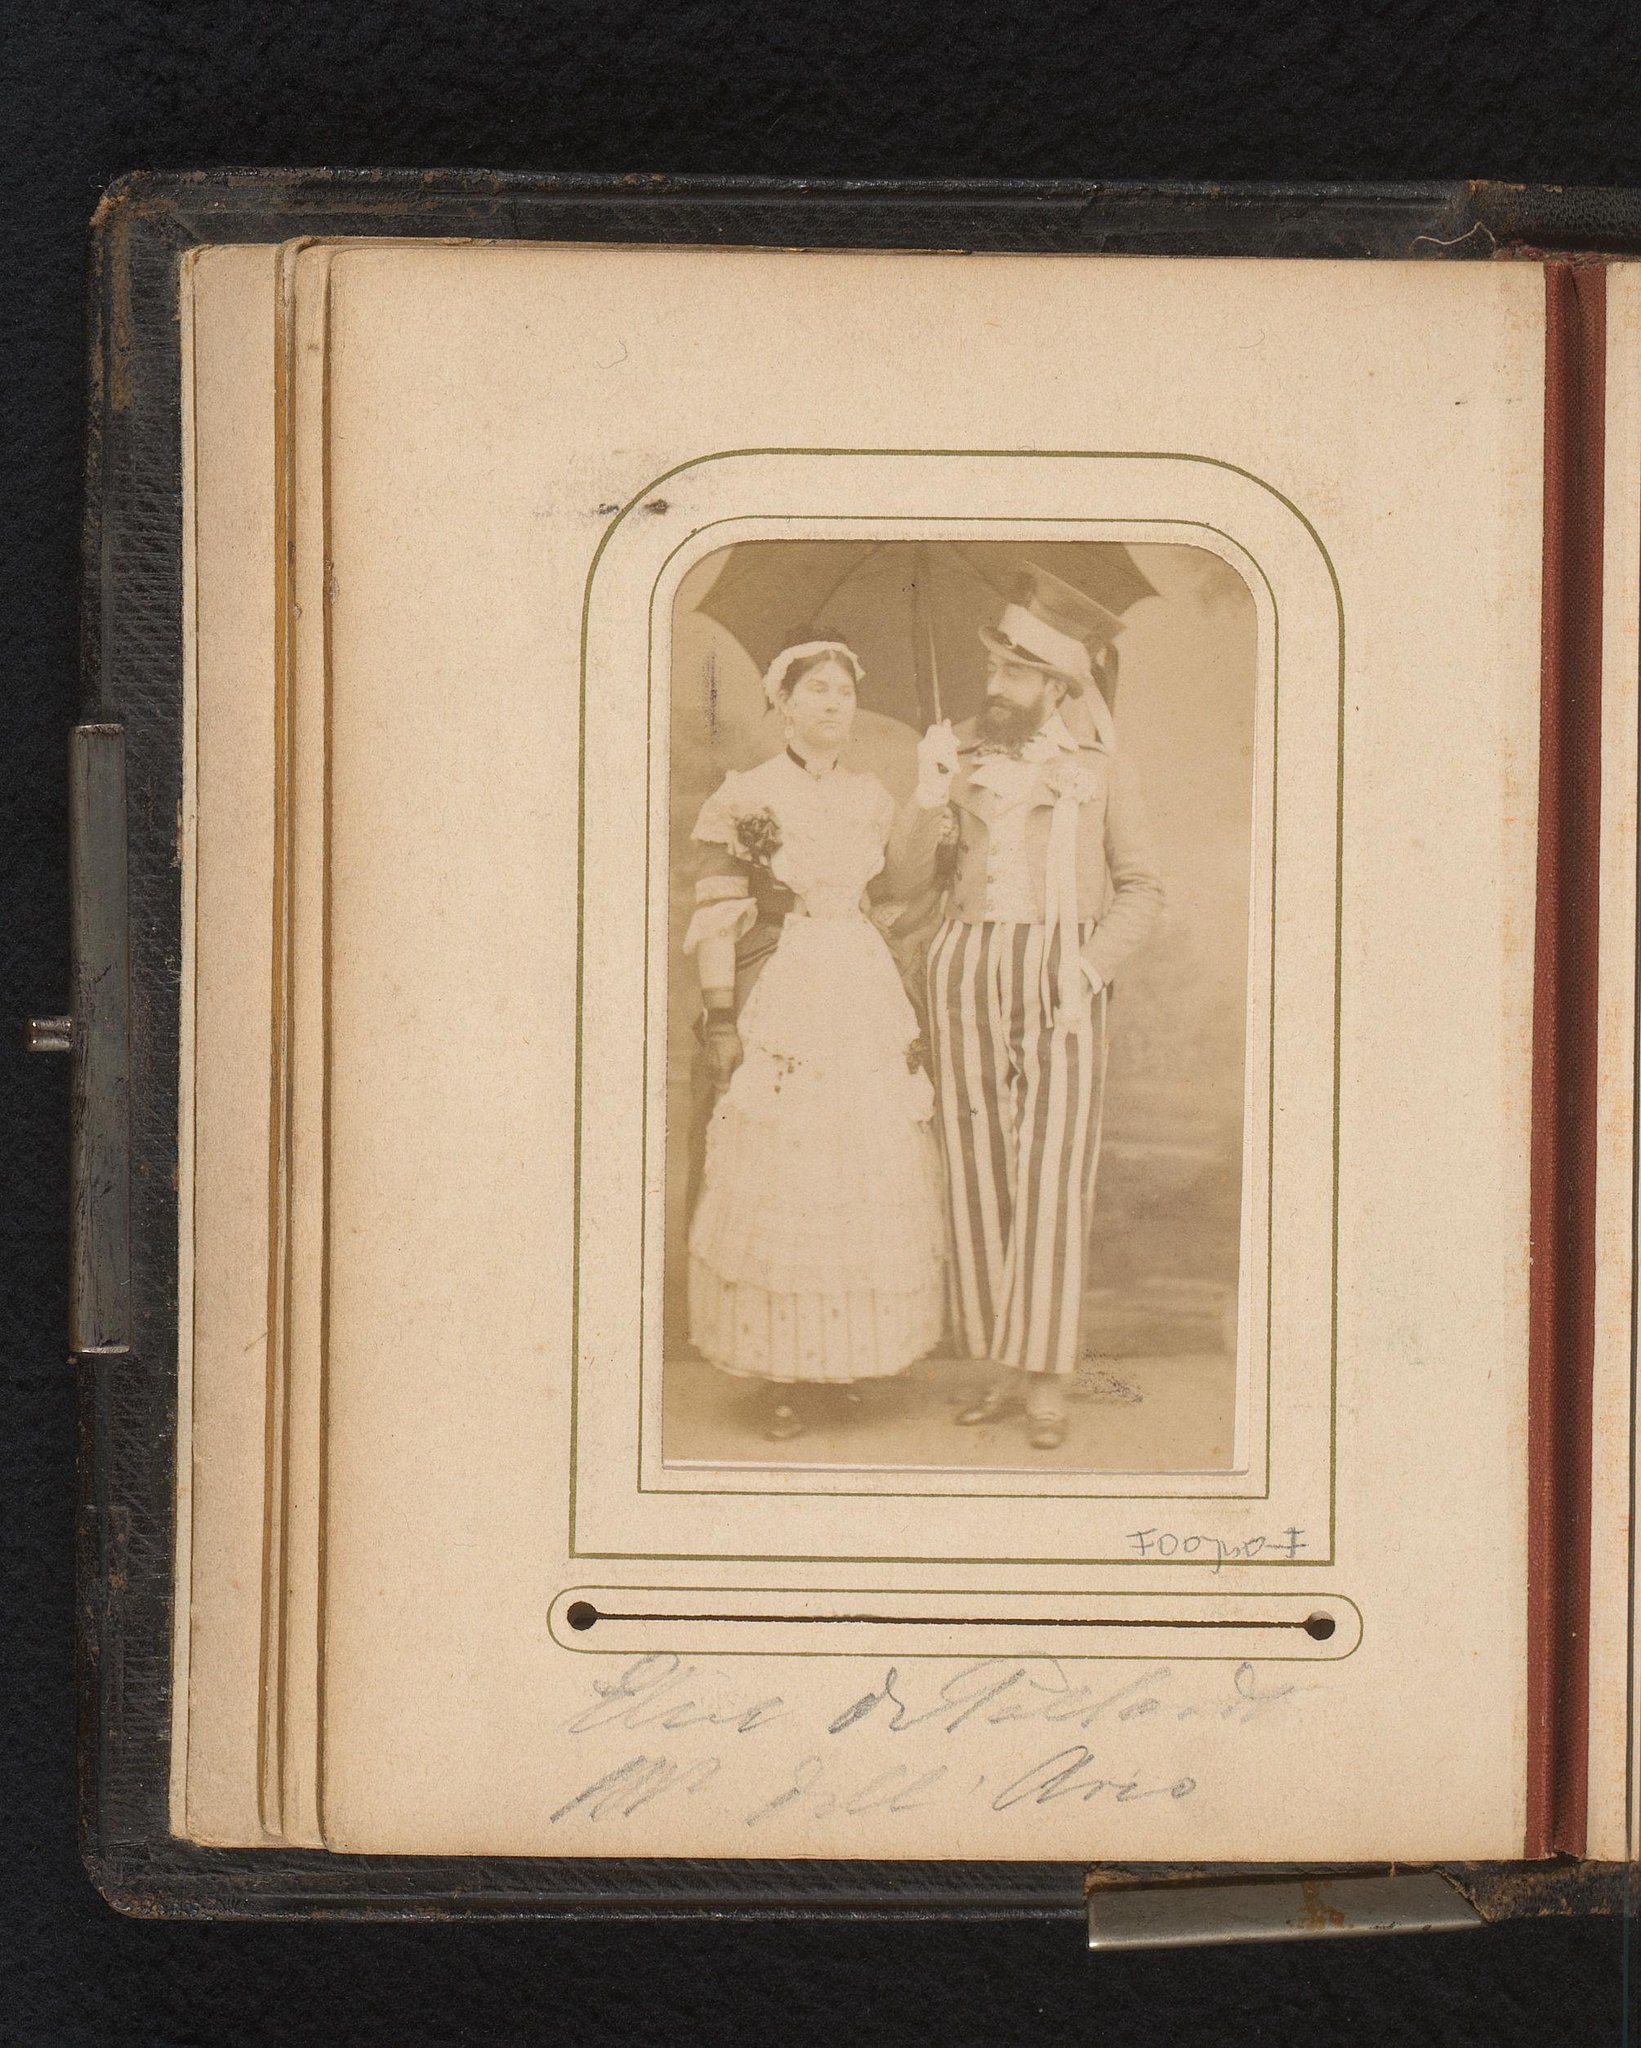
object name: album leaf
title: Portret van een man en vrouw, aangeduid als Eline de Pallandt en Dell'Avo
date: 1877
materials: cardboard, photographic support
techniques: albumen print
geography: the hague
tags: historical persons - bb - woman, historical persons, umbrella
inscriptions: annotation: ‘[Eline de Pallandt/ Mr Dell'Avo]’, inscription: ‘De Lavieter & Co./ Photographes/ Willemstraat No2/ La Haye’